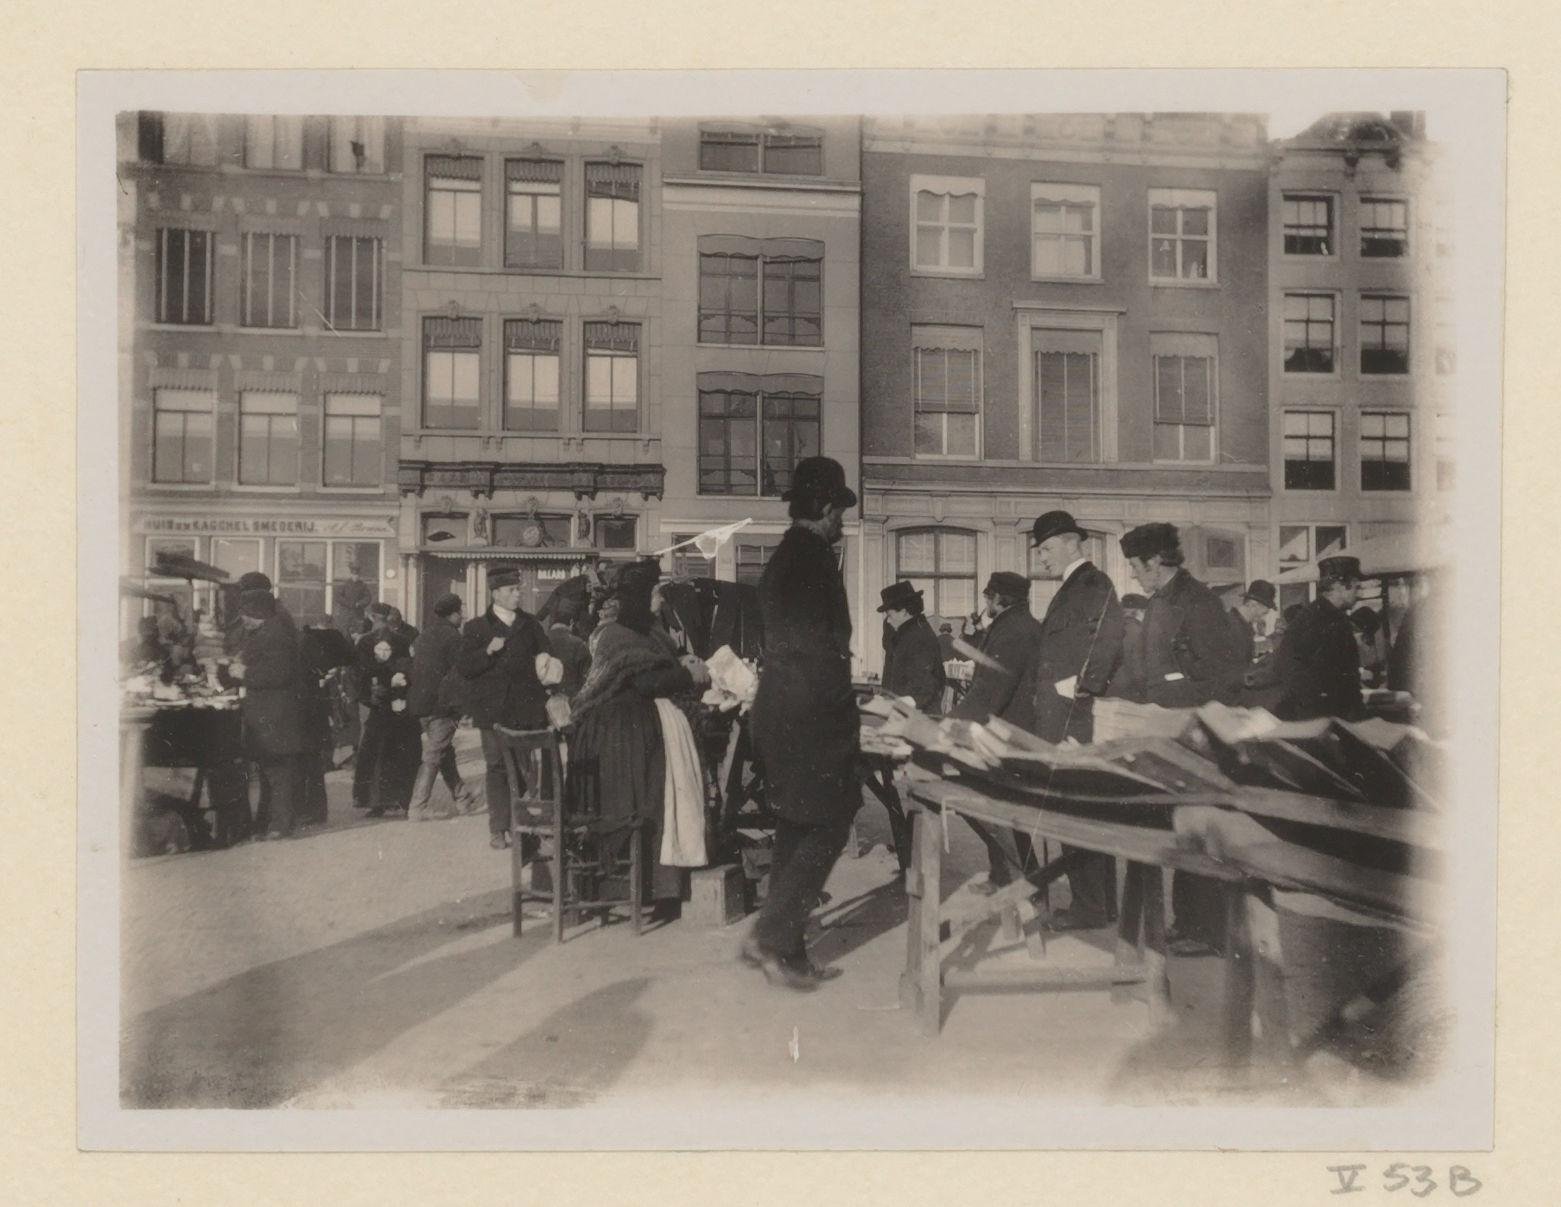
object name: photograph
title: Gezicht op de maandagmarkt op het Amstelveld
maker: Anonymous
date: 1880-1950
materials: paper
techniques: gelatin silver print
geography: amsterdam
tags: square, place, circus, etc., city-view in general; 'veduta', stall, booth (~ market), market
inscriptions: collector's mark: ‘5’ Lugt 1641b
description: Onderwerpsrubriek binnen de Atlas Amsterdam: Amstelgrachtje, Amstelkanaal (Noorder-), Amstelveld, Amstelstraat (Nieuwe), Annadwarsstraat, Anthoniebreestraat.